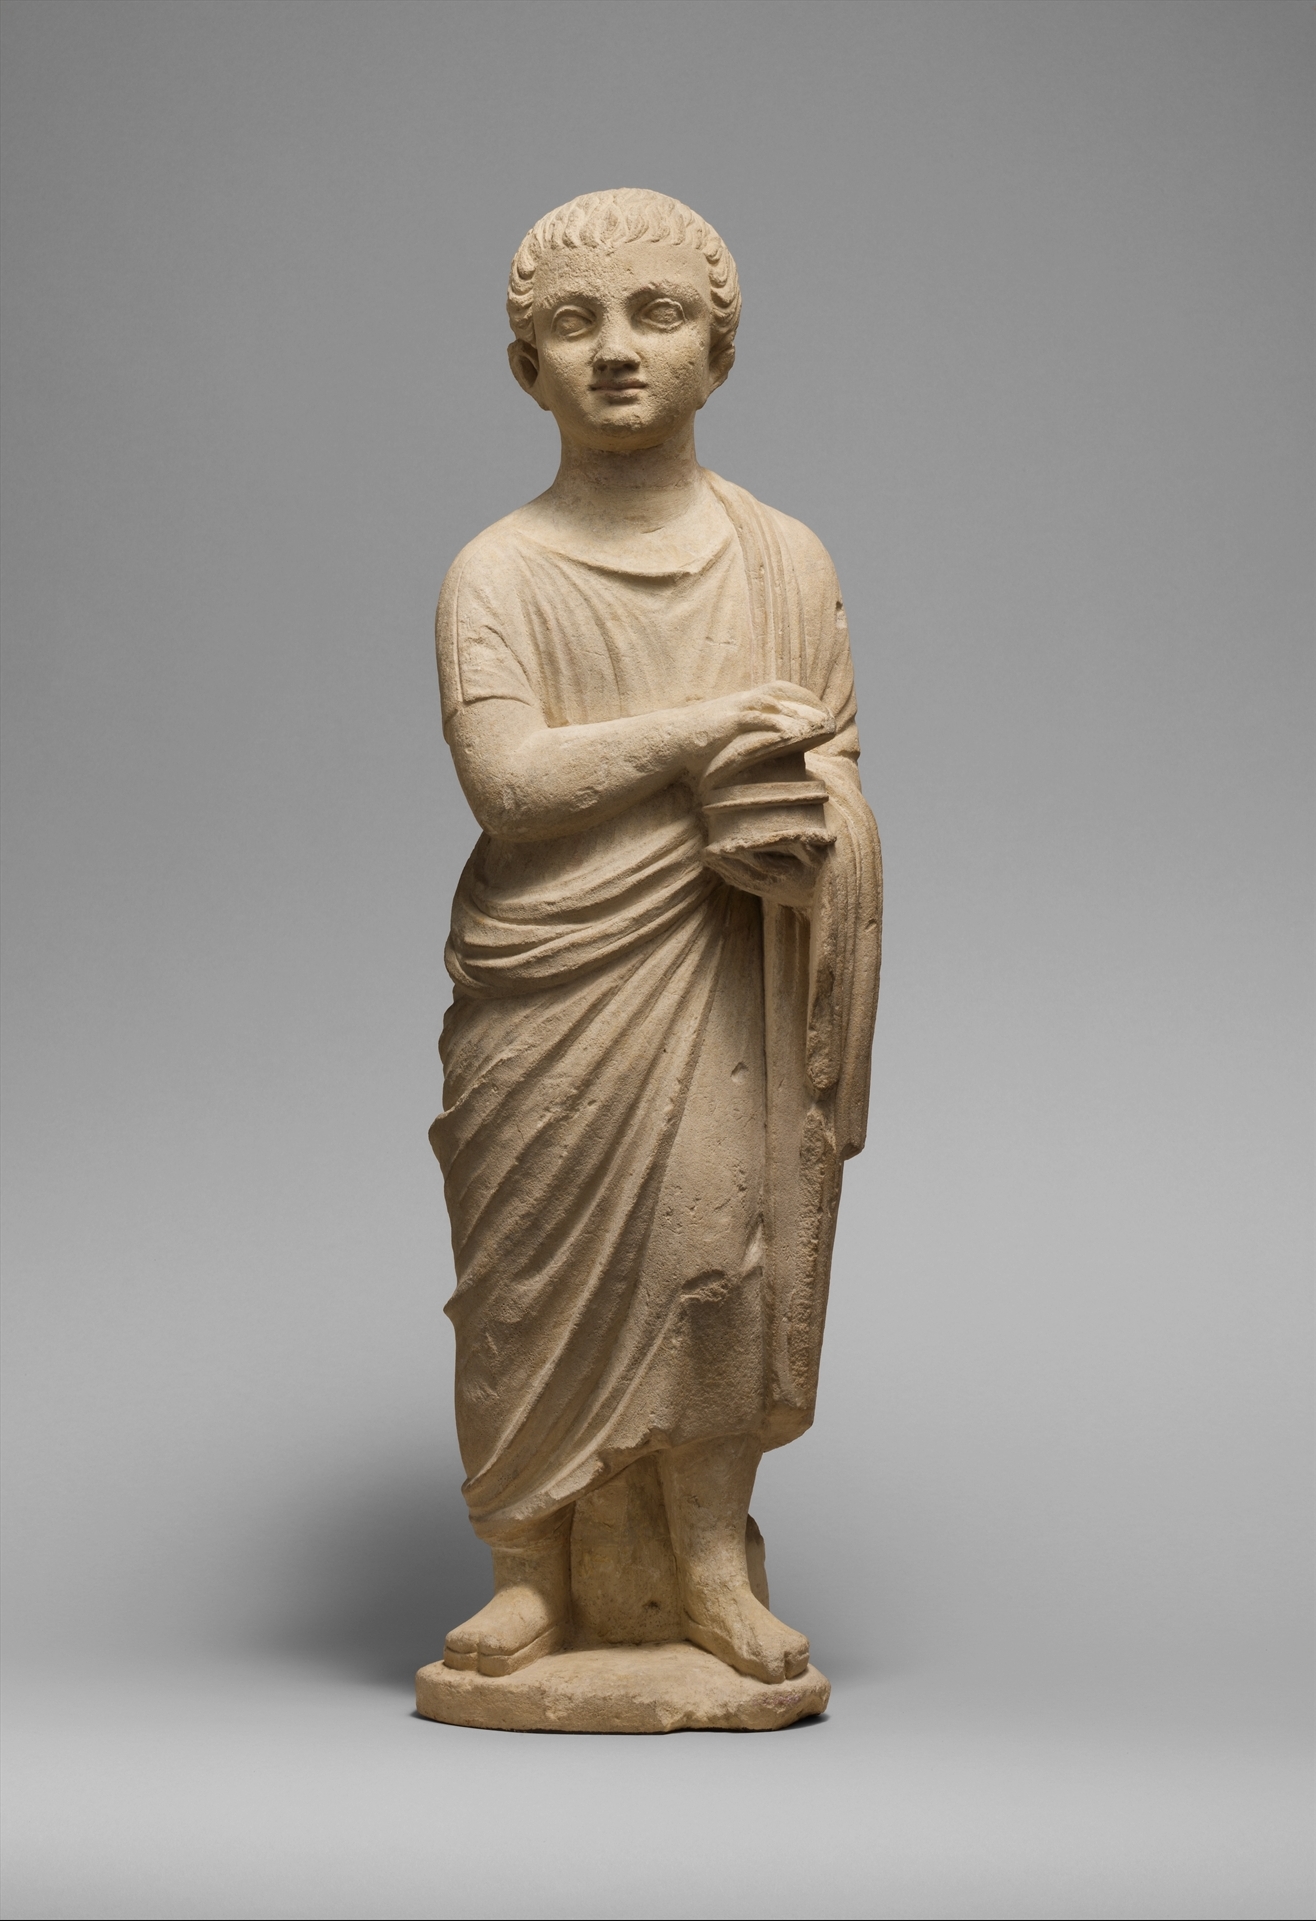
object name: statue of a male votary holding an incense box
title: Limestone statue of a youth holding a pyxis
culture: cypriot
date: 300-1 BCE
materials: limestone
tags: boys